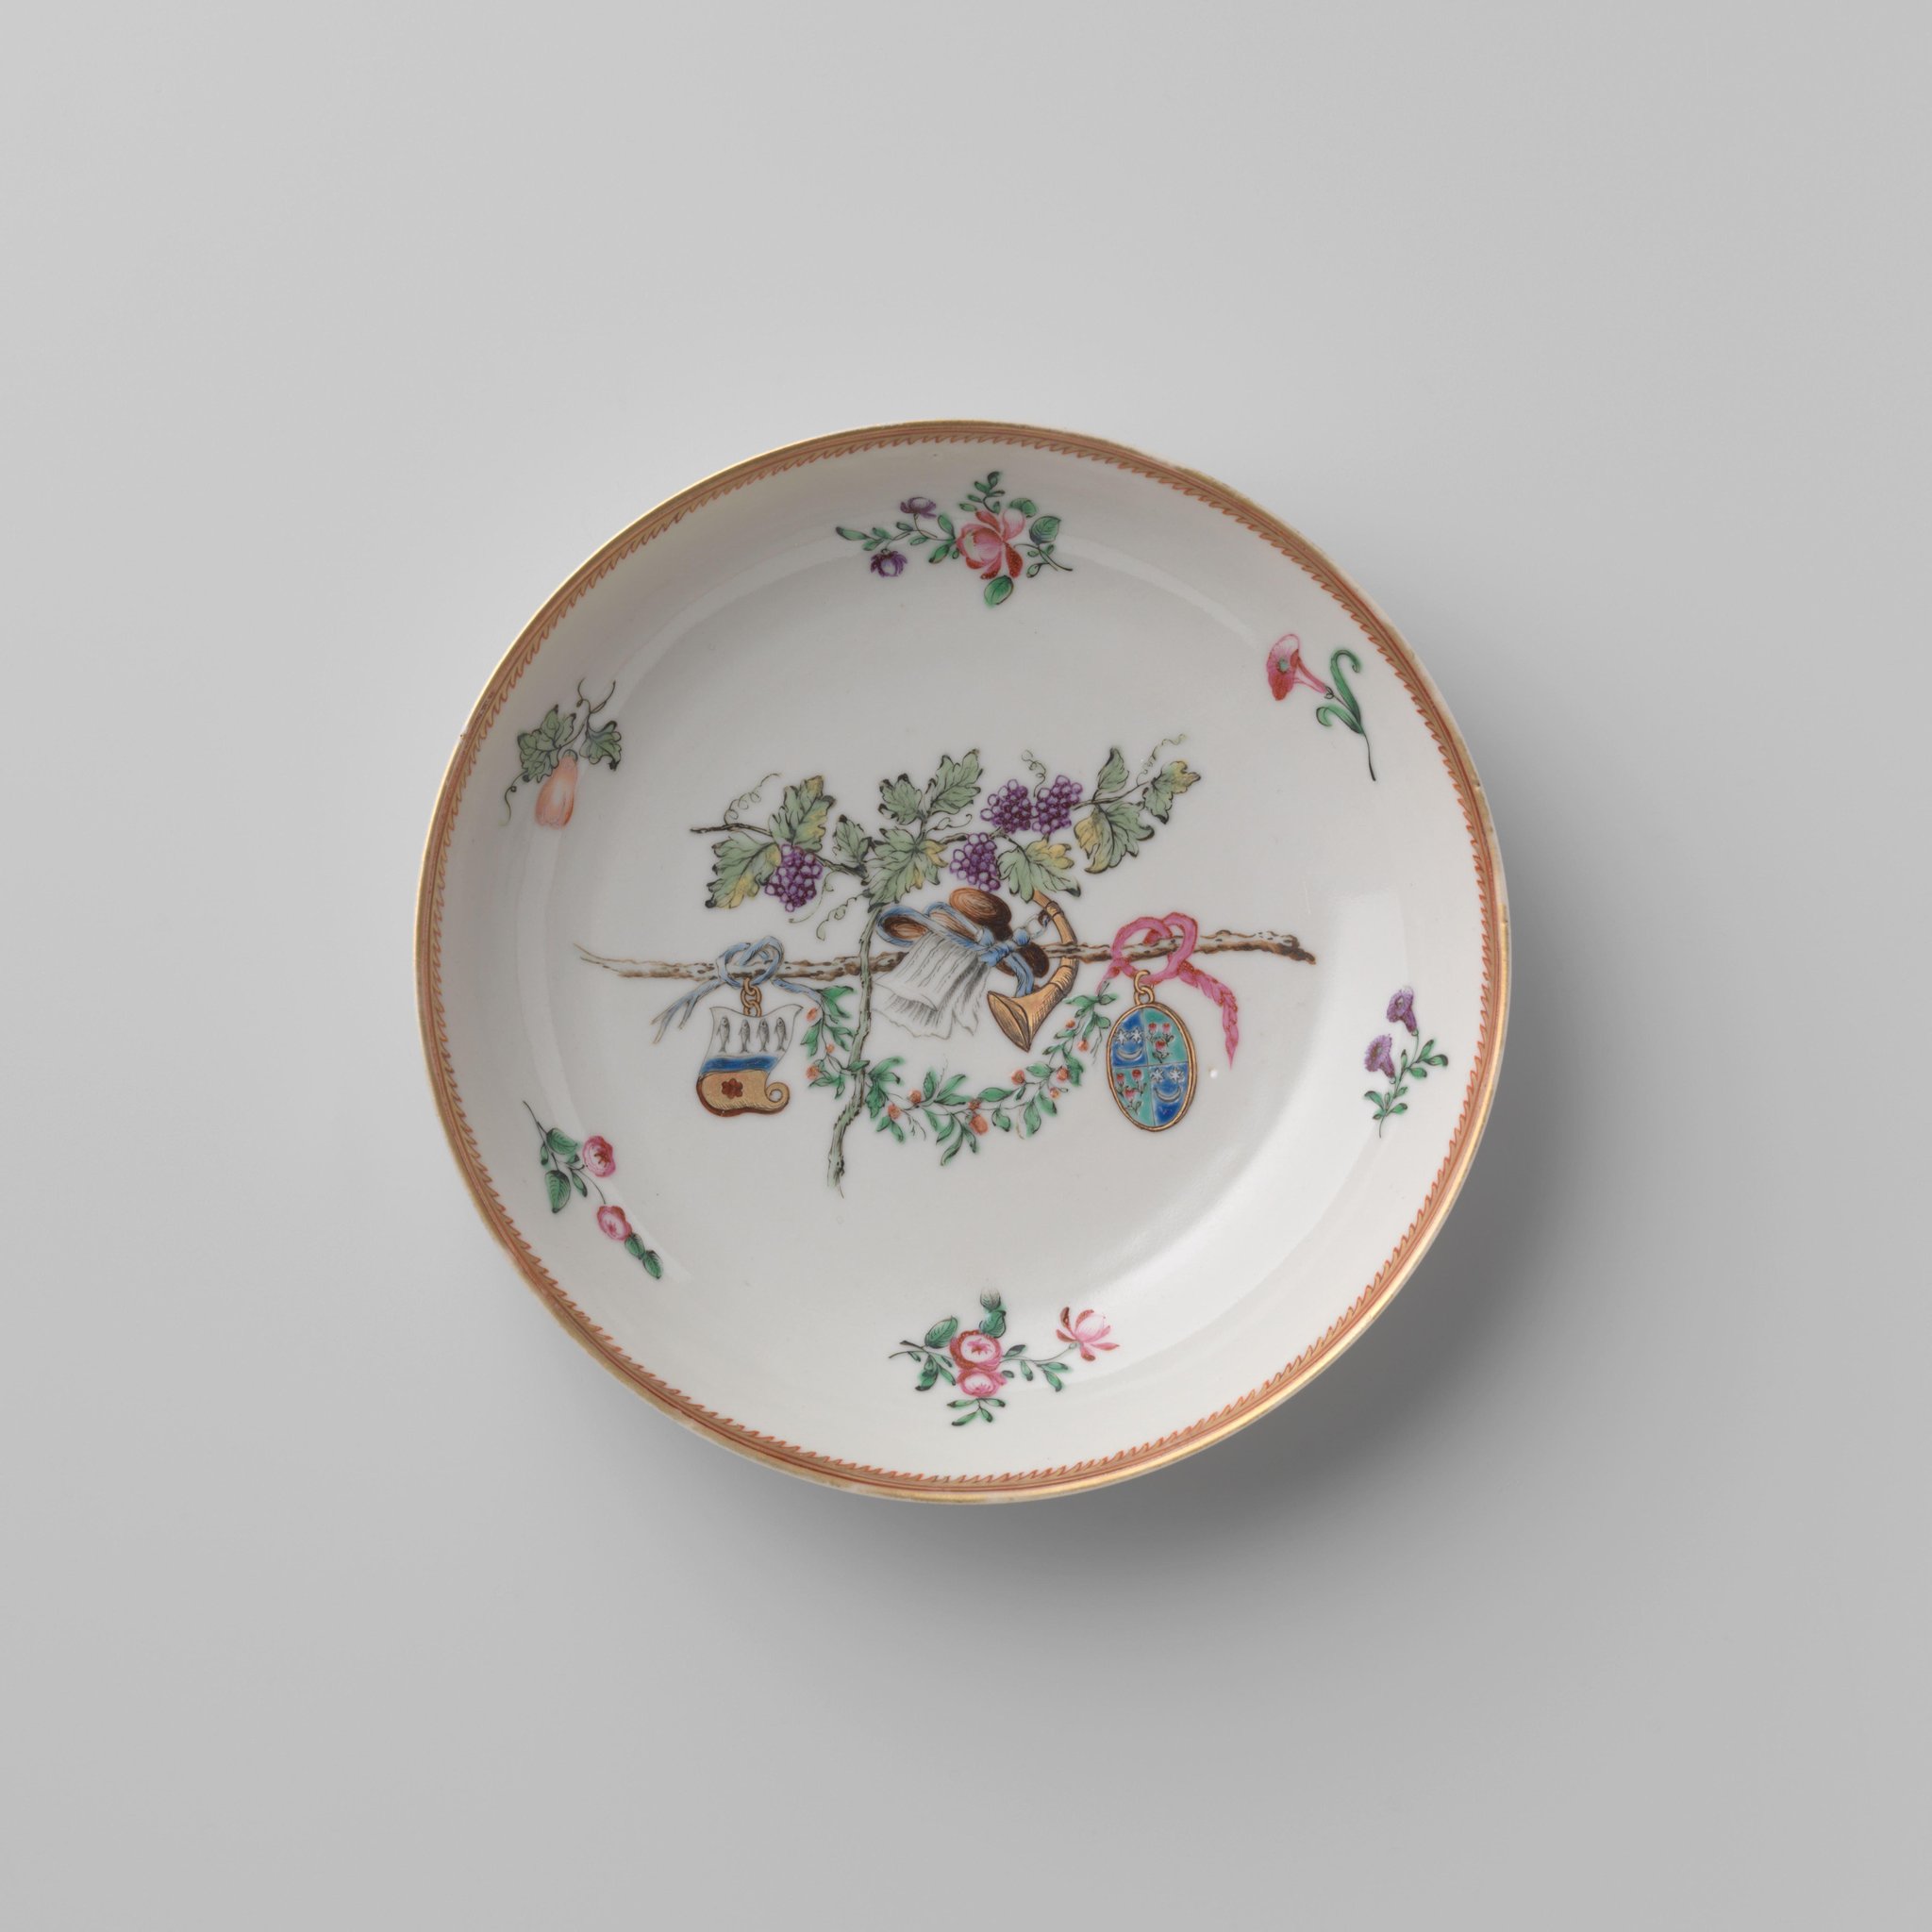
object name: platter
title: Saucer with the arms of the Visvliet and Sluymer families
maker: Anonymous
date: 1777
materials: glaze, gold, paint, porcelain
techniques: firing, gilding, turning, vitrification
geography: china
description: Kop en schotel van porselein. Versierd met bloem- en vruchtentakken en een stok waaraan een hoed, een blad papier een hoorn en 2 wapenschilden zijn bevestigd. De wapens zijn van de families Visvliet en Sluymer (uit Zeeland).